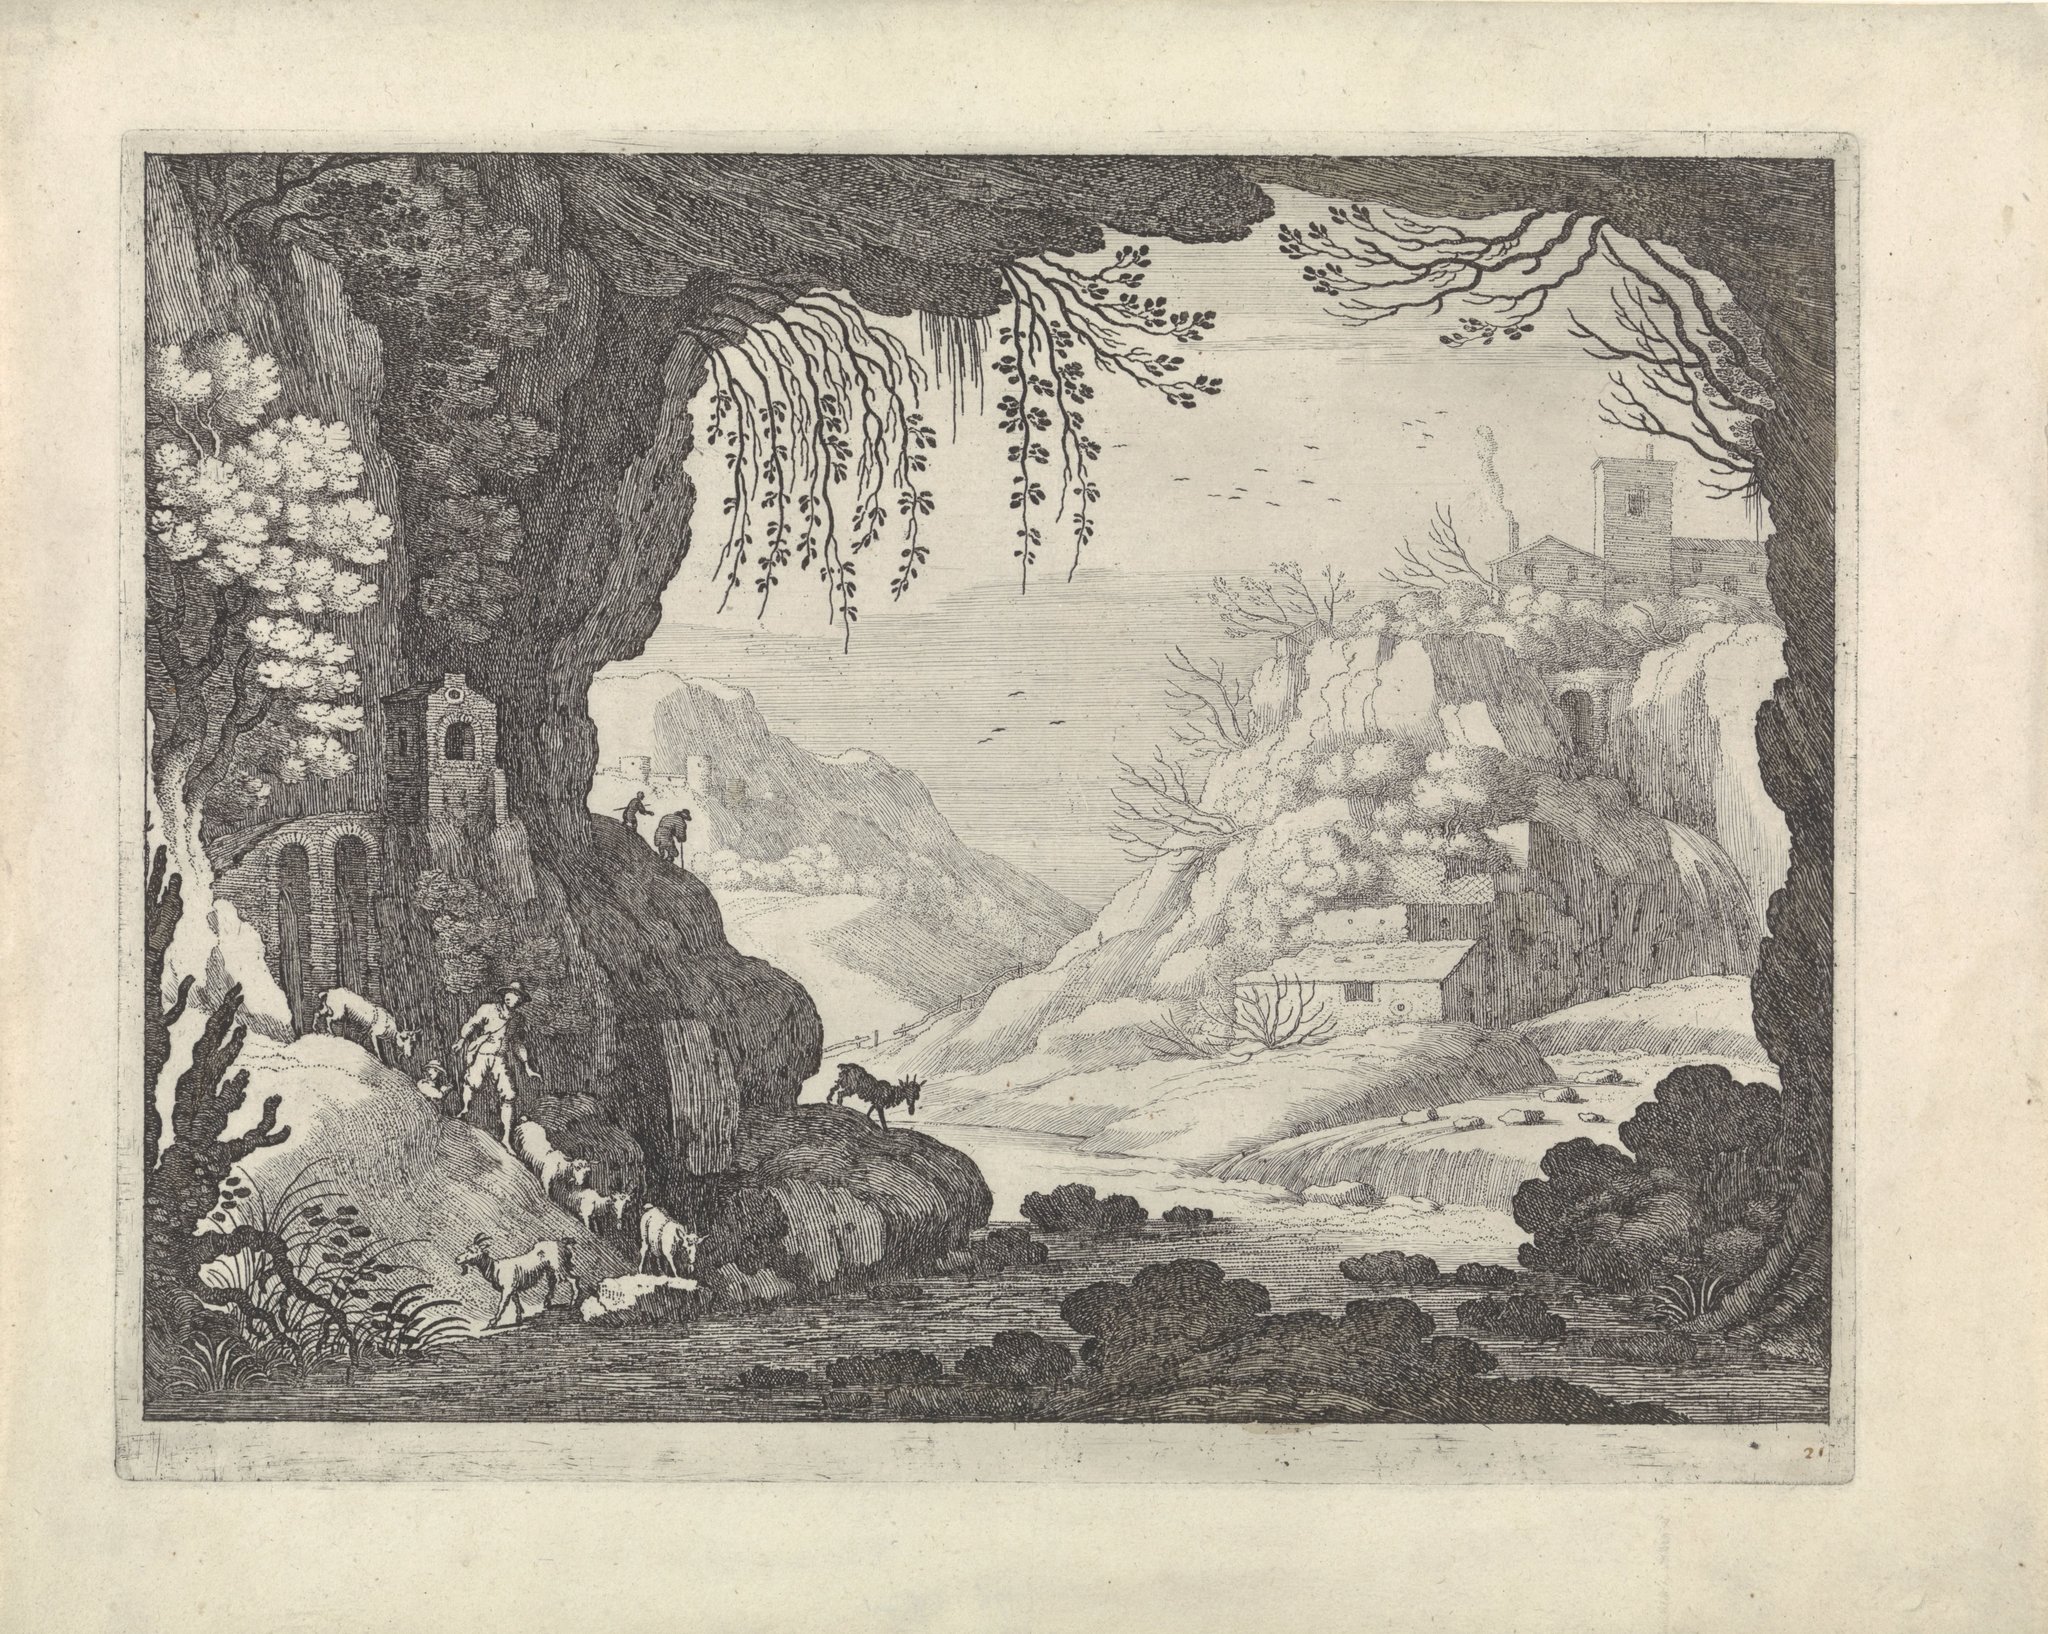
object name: print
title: Uitzicht op landschap vanuit grot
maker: guilliam van nieulandt (ii)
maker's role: draughtsman, print maker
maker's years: 1584-1635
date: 1594-1635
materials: paper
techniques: brush, engraving, etching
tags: river, herding, herdsman, herdswoman, shepherd, shepherdess, cowherd, etc., cave, grotto, goat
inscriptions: inscription: ‘21’, collector's mark: Lugt 2760, collector's mark: Lugt 2228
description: Vanuit een grot, waarin een rivier stroomt, uitzicht op een bergachtig landschap. Links op de oever twee herders met een kudde geiten.